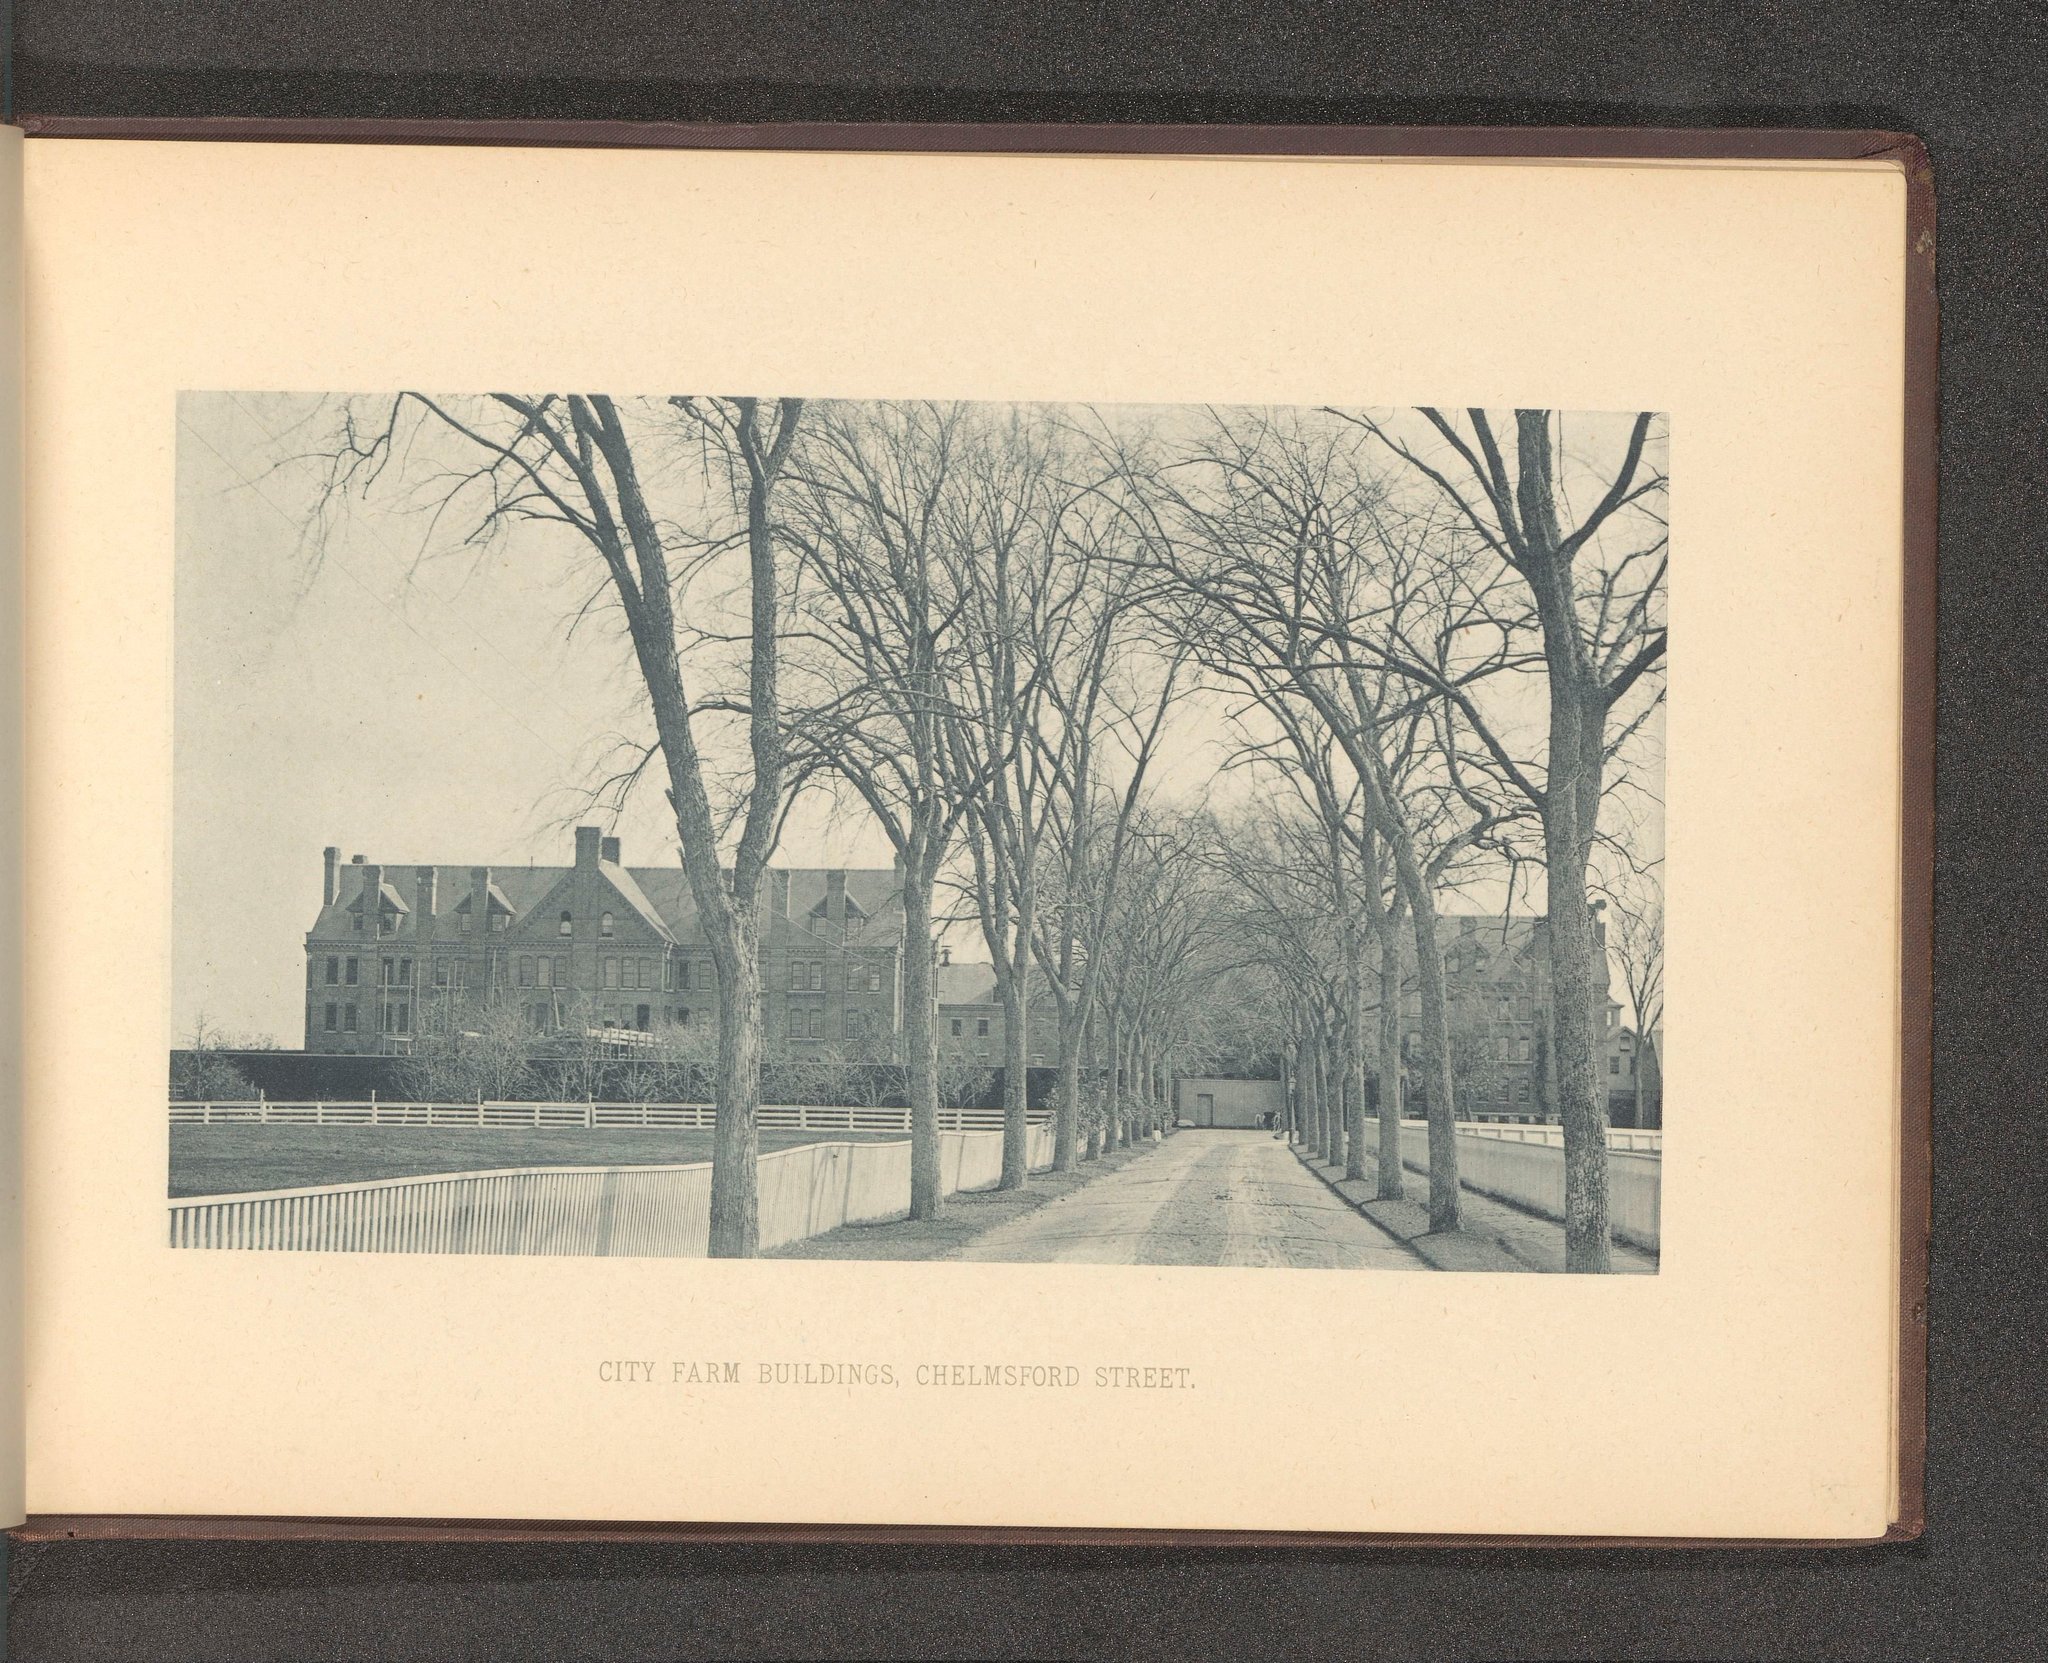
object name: photomechanical print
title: City farm buildings, Chelmsford street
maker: Anonymous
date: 1887-1892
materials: paper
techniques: photograph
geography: lowell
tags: façade (of house or building), farm (building)